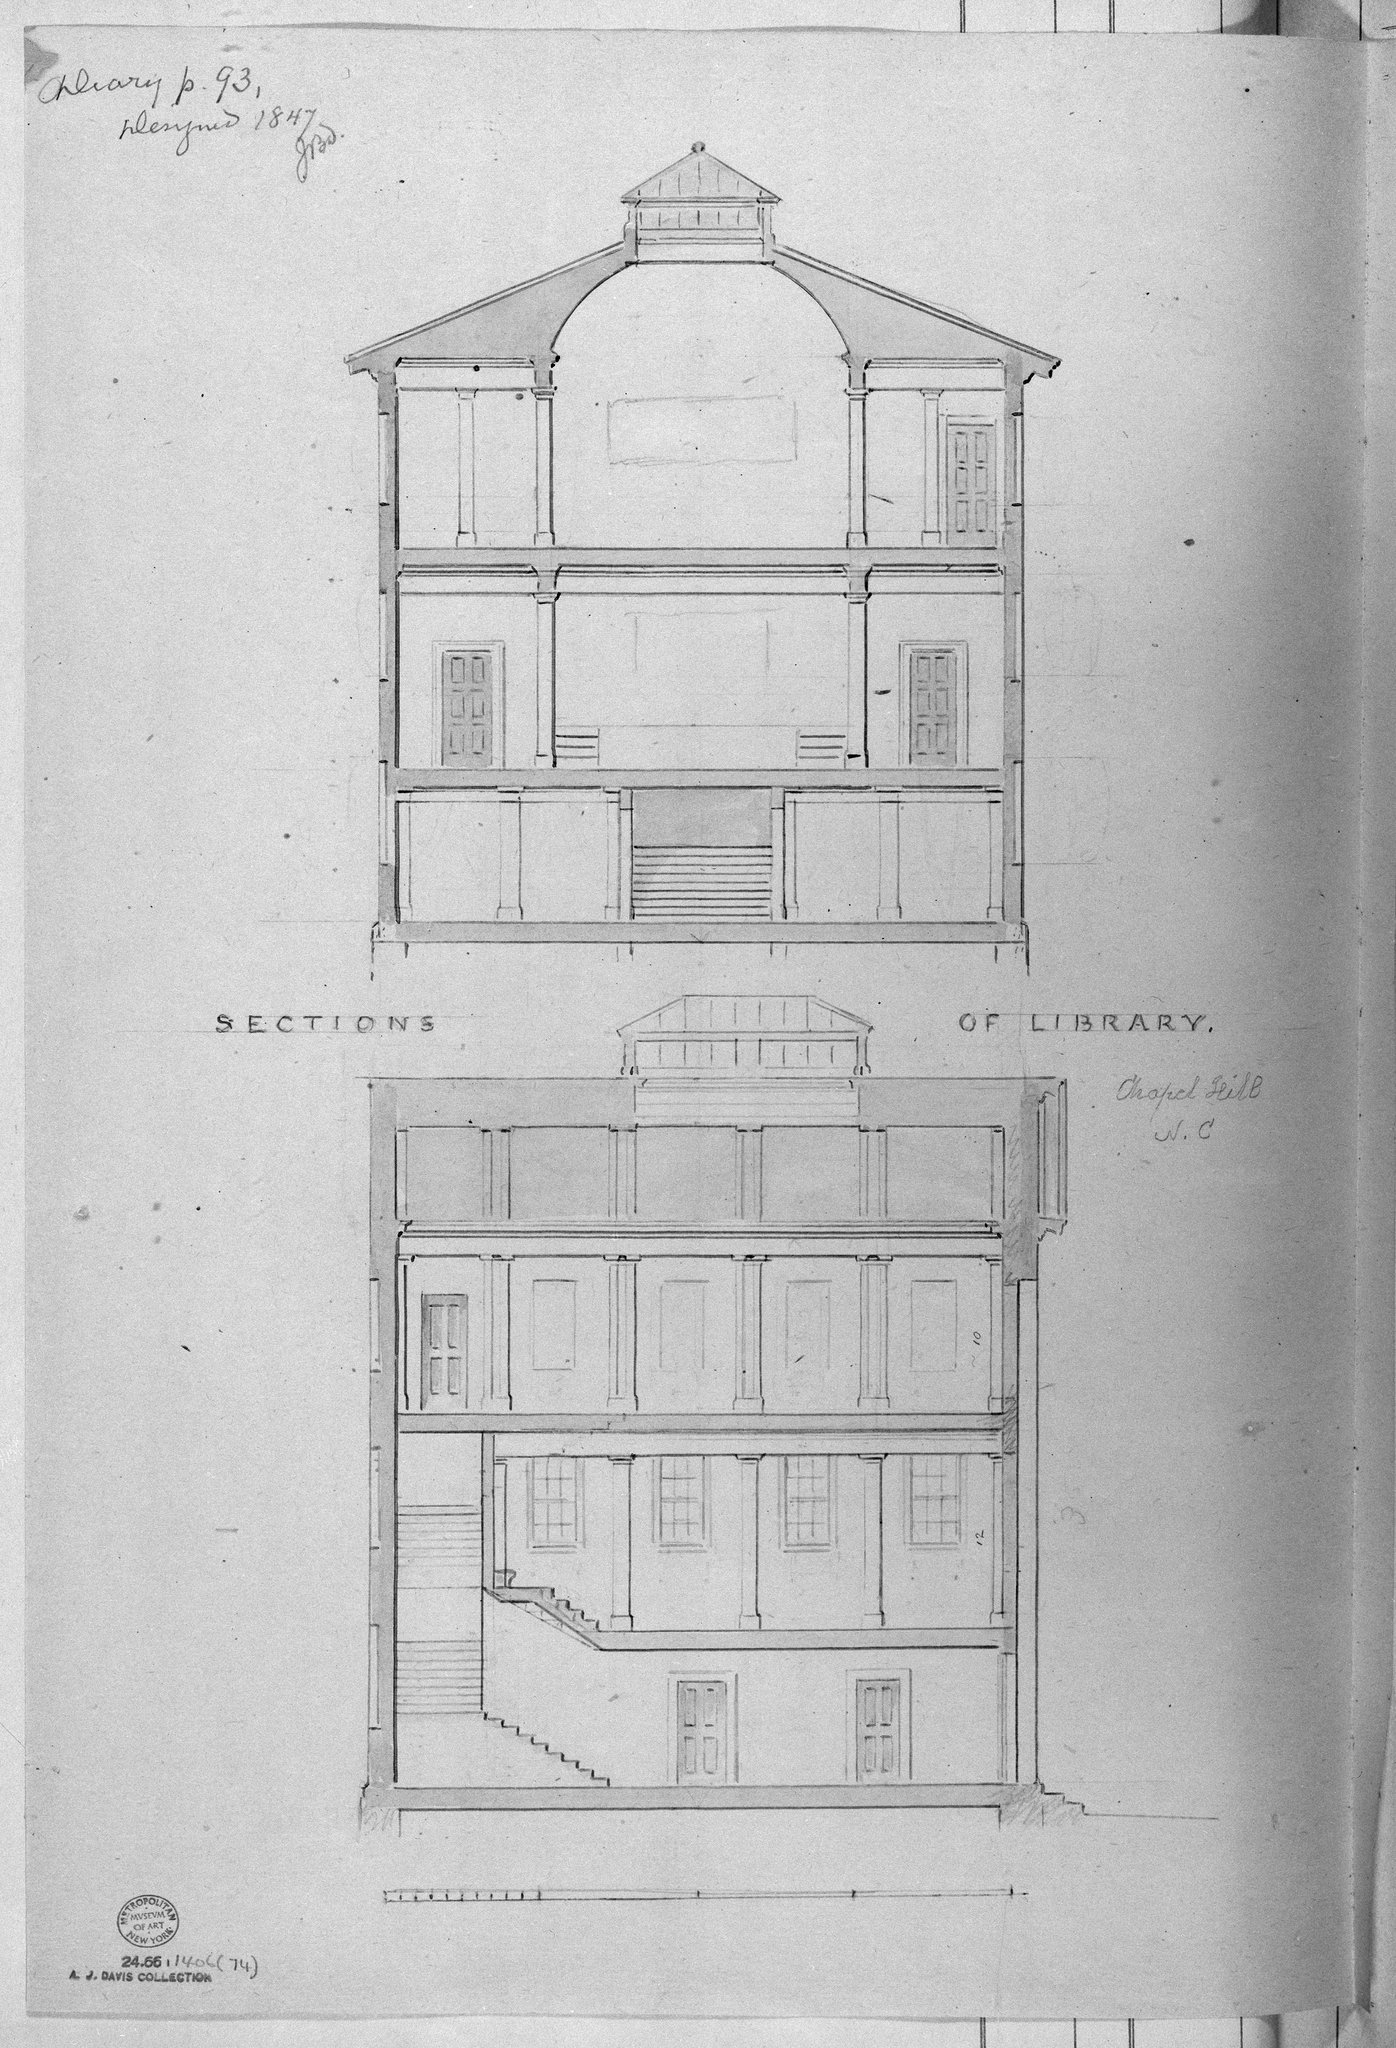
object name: drawing ornament architecture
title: University of North Carolina, Chapel Hill, Student Libraries (two sections)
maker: alexander jackson davis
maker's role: artist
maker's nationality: american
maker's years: 1803-1892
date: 1850-1858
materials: graphite, ink, watercolor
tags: architecture